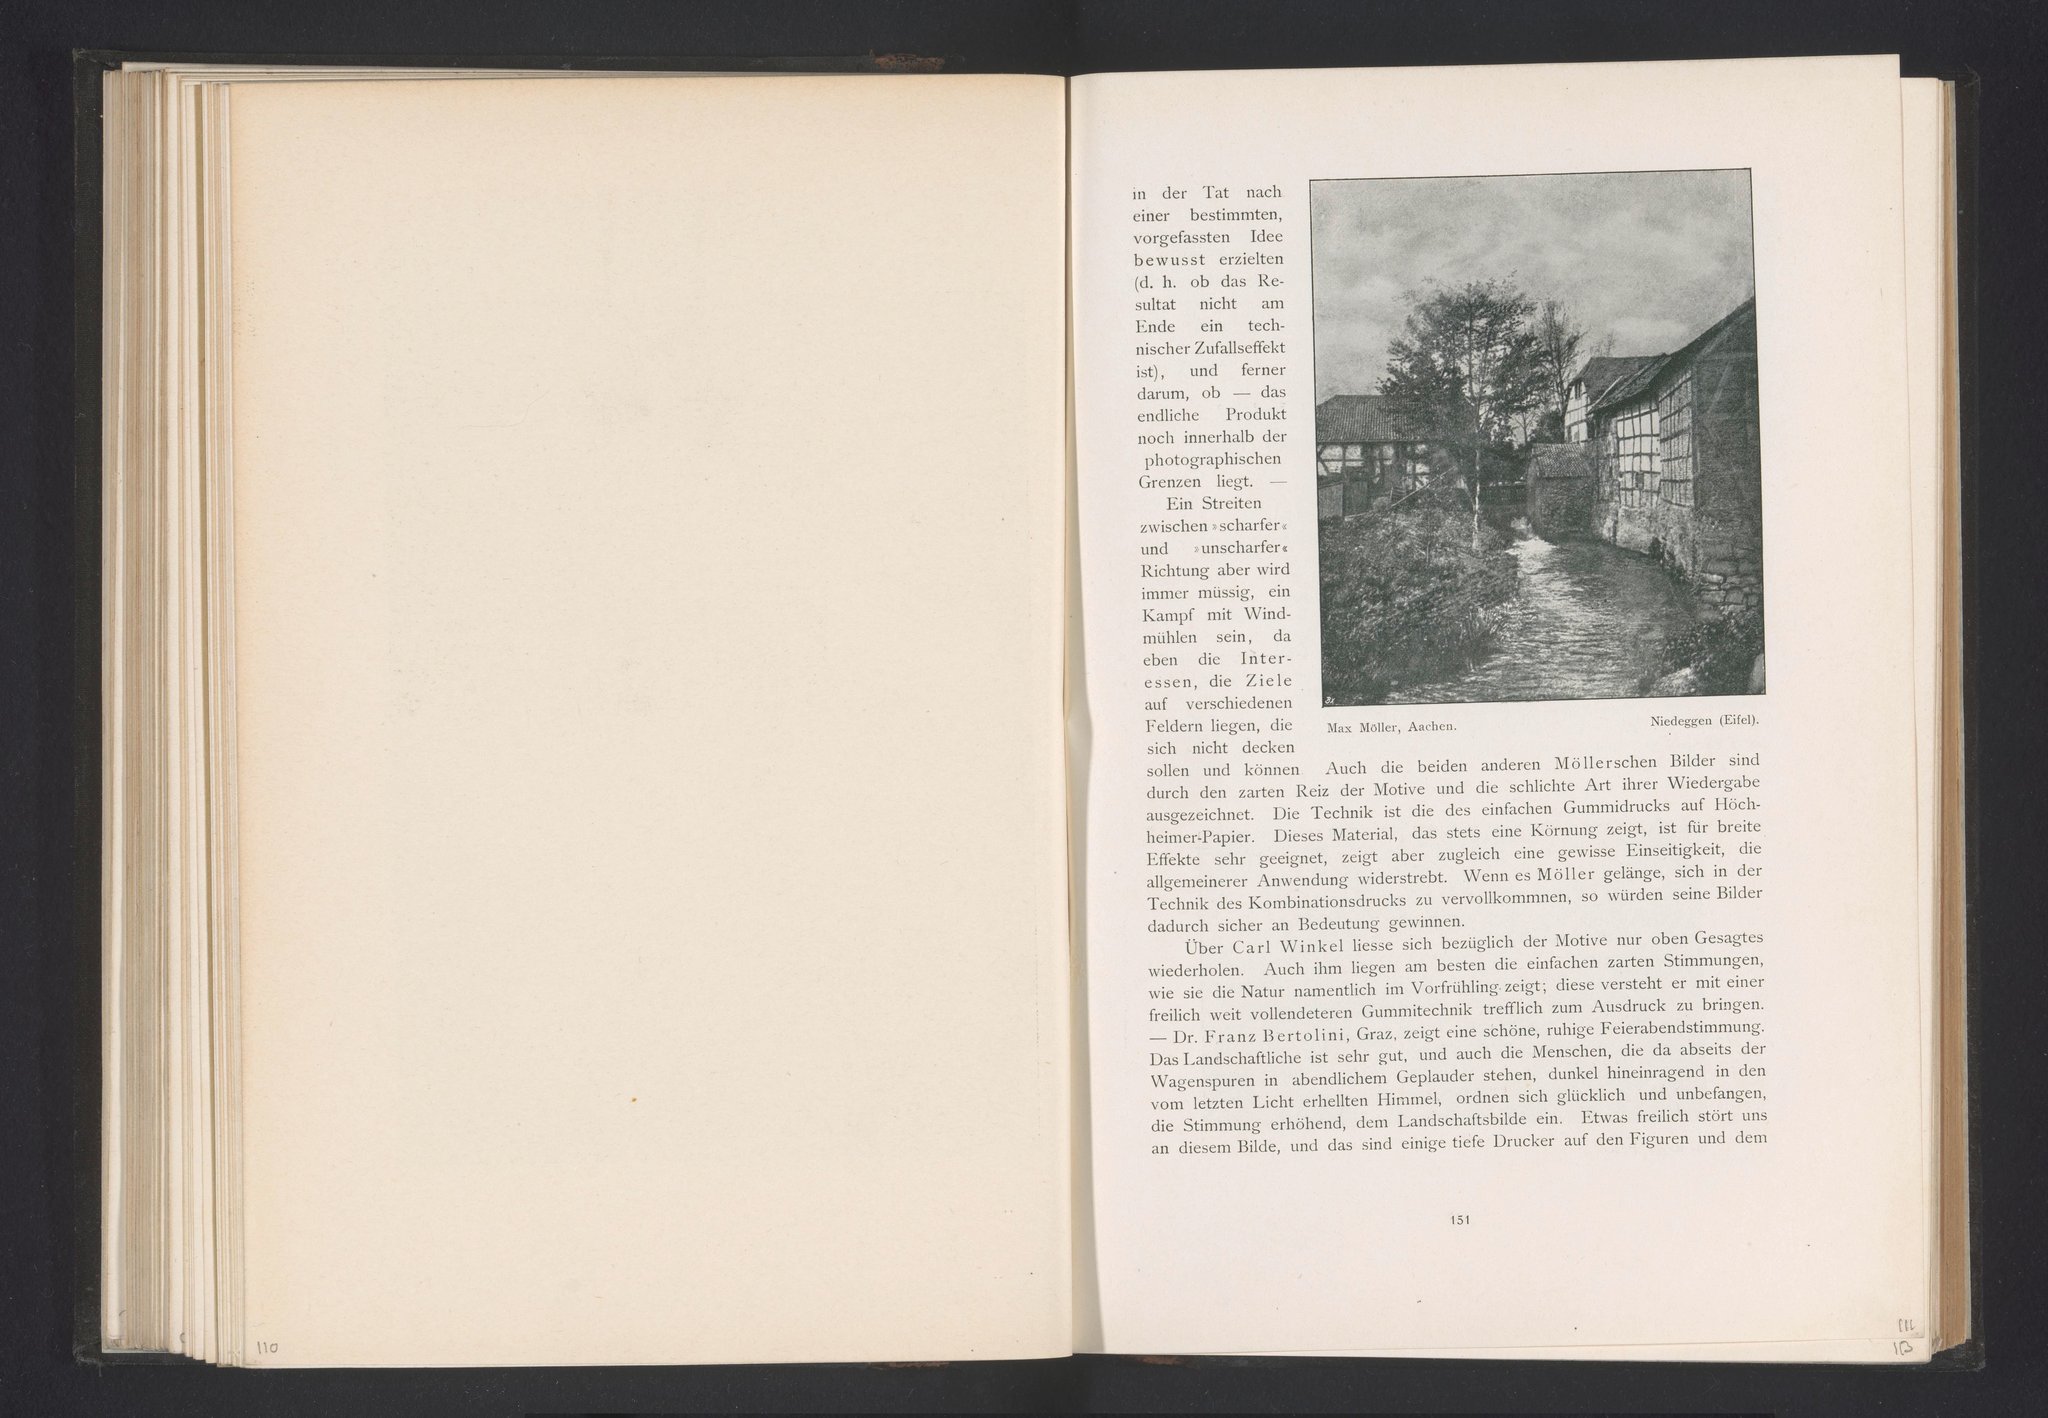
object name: page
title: Gezicht op Nideggen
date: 1898-1903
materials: paper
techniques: autotype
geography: nideggen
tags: city-view in general; 'veduta'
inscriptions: monogram: ‘BX’